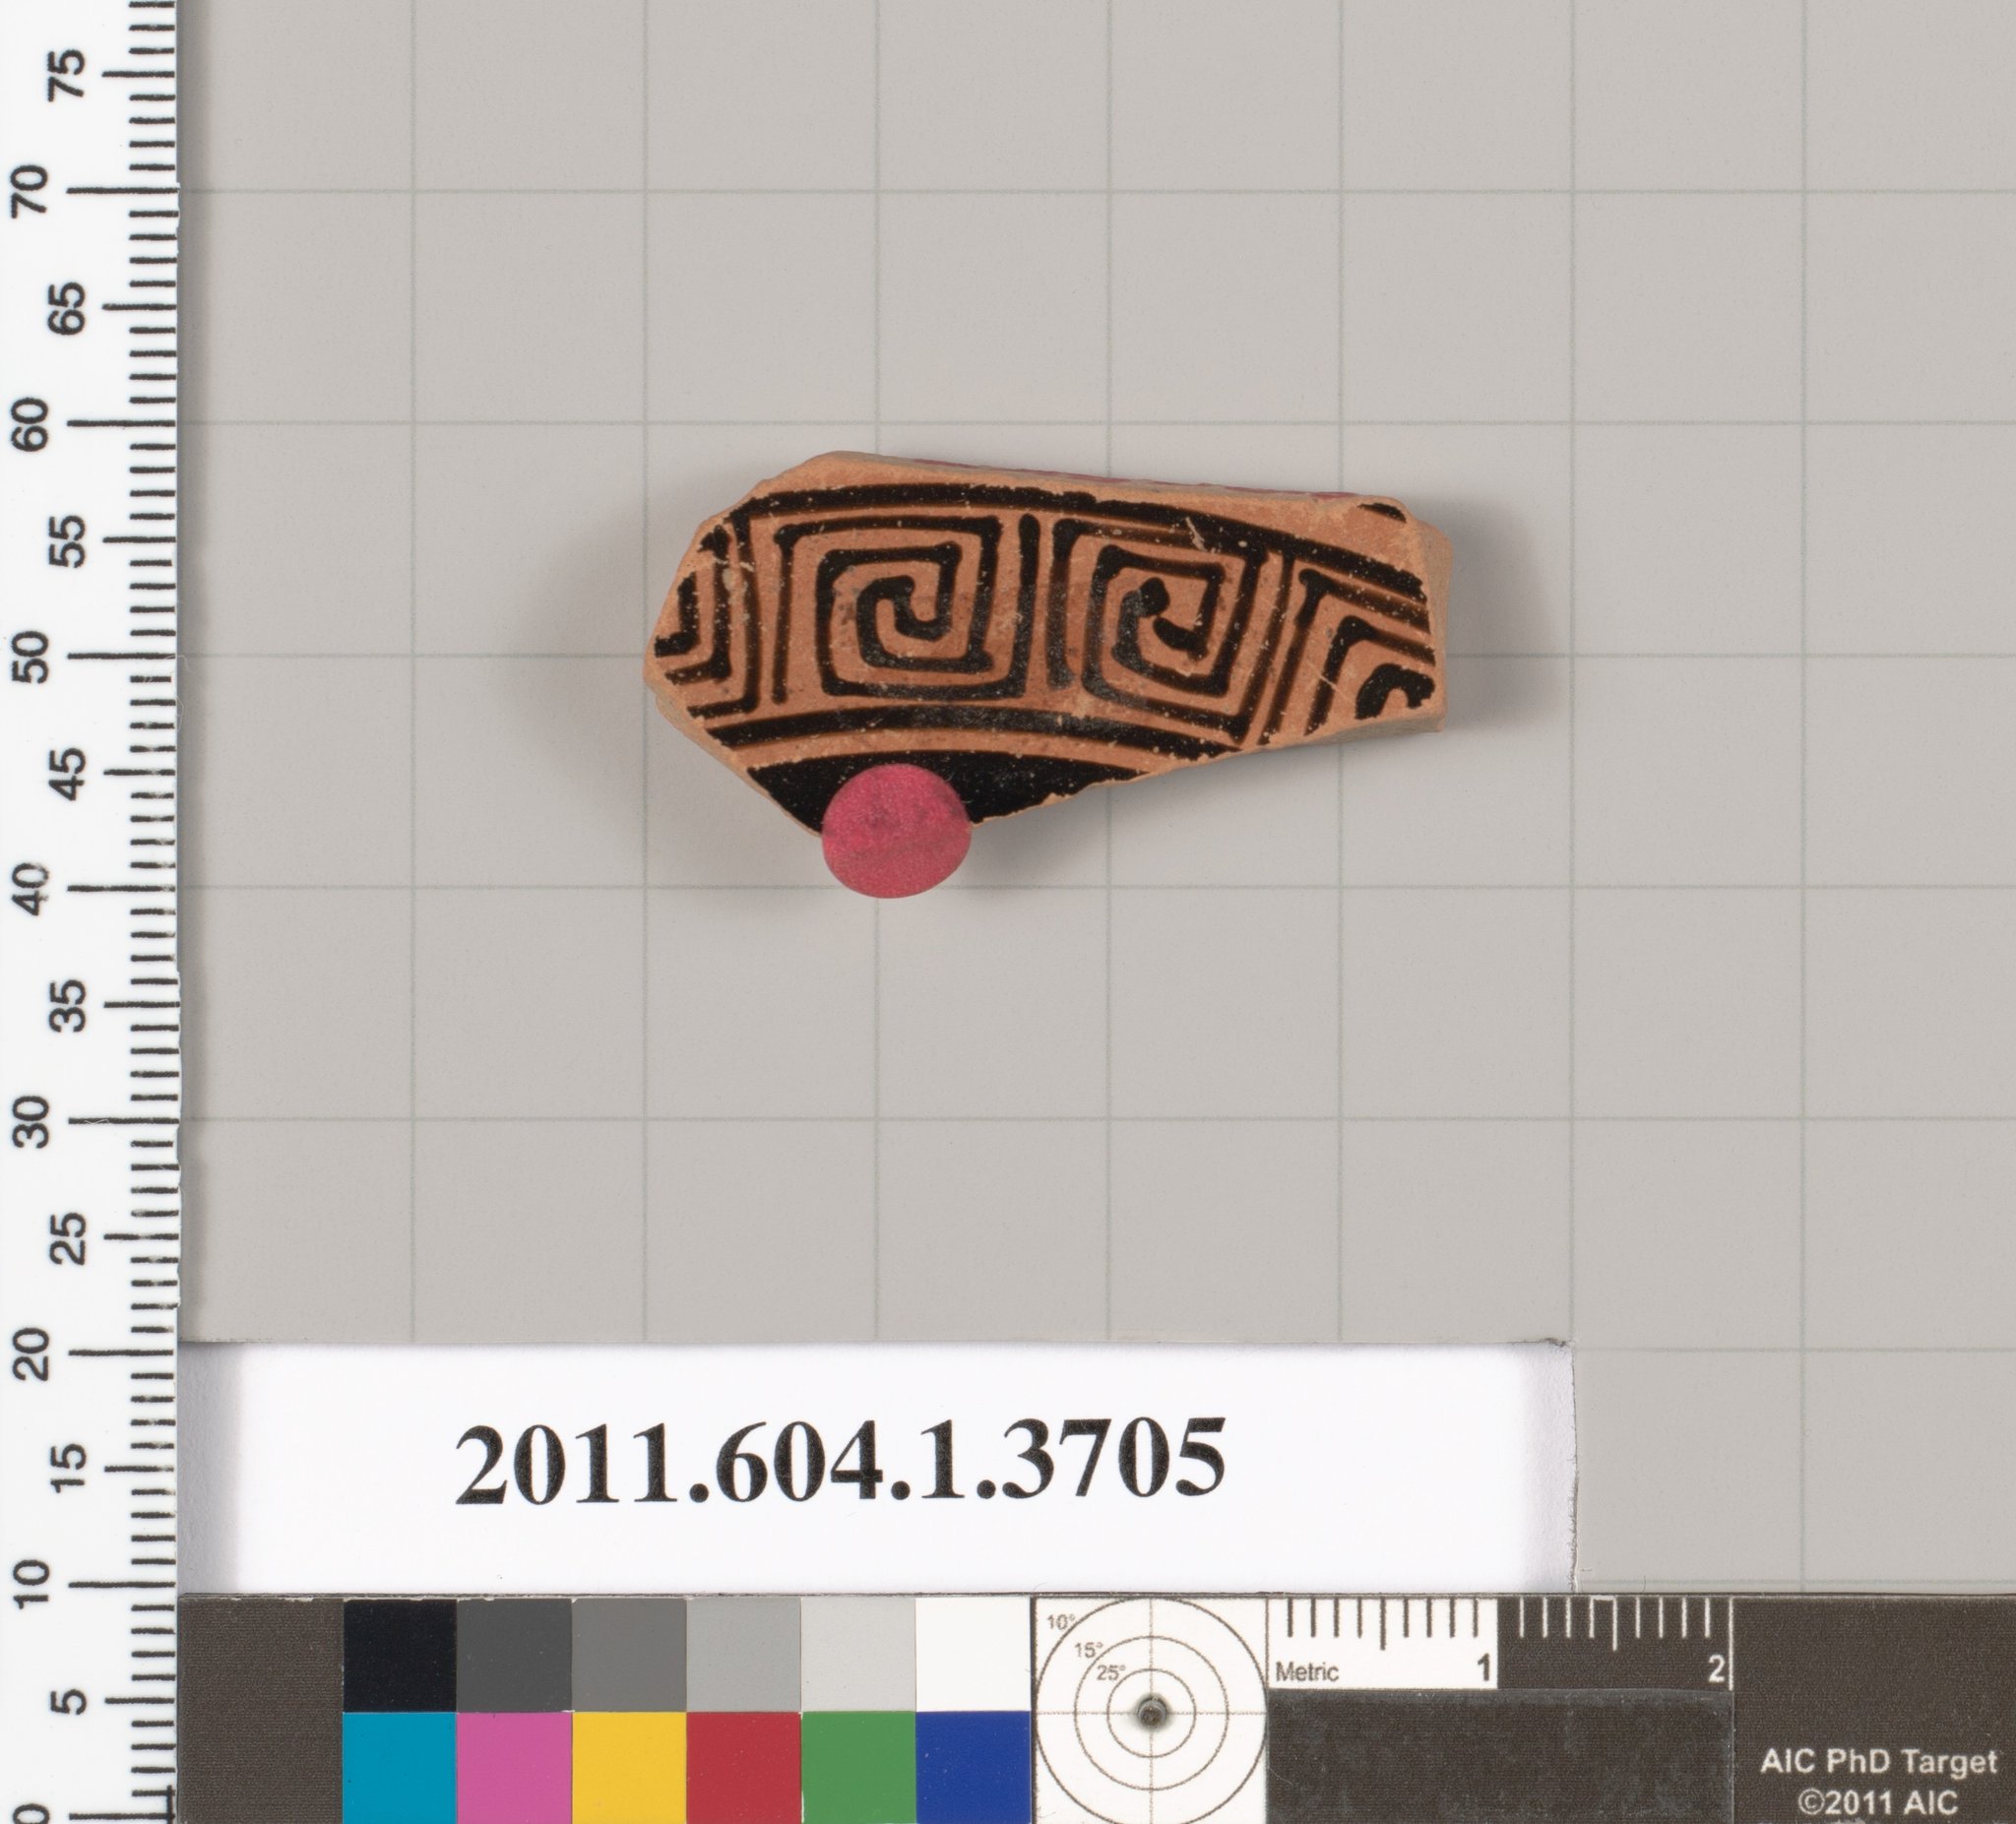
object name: kylix fragment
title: Terracotta fragment of a kylix (drinking cup)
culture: greek, attic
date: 500-480 BCE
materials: terracotta